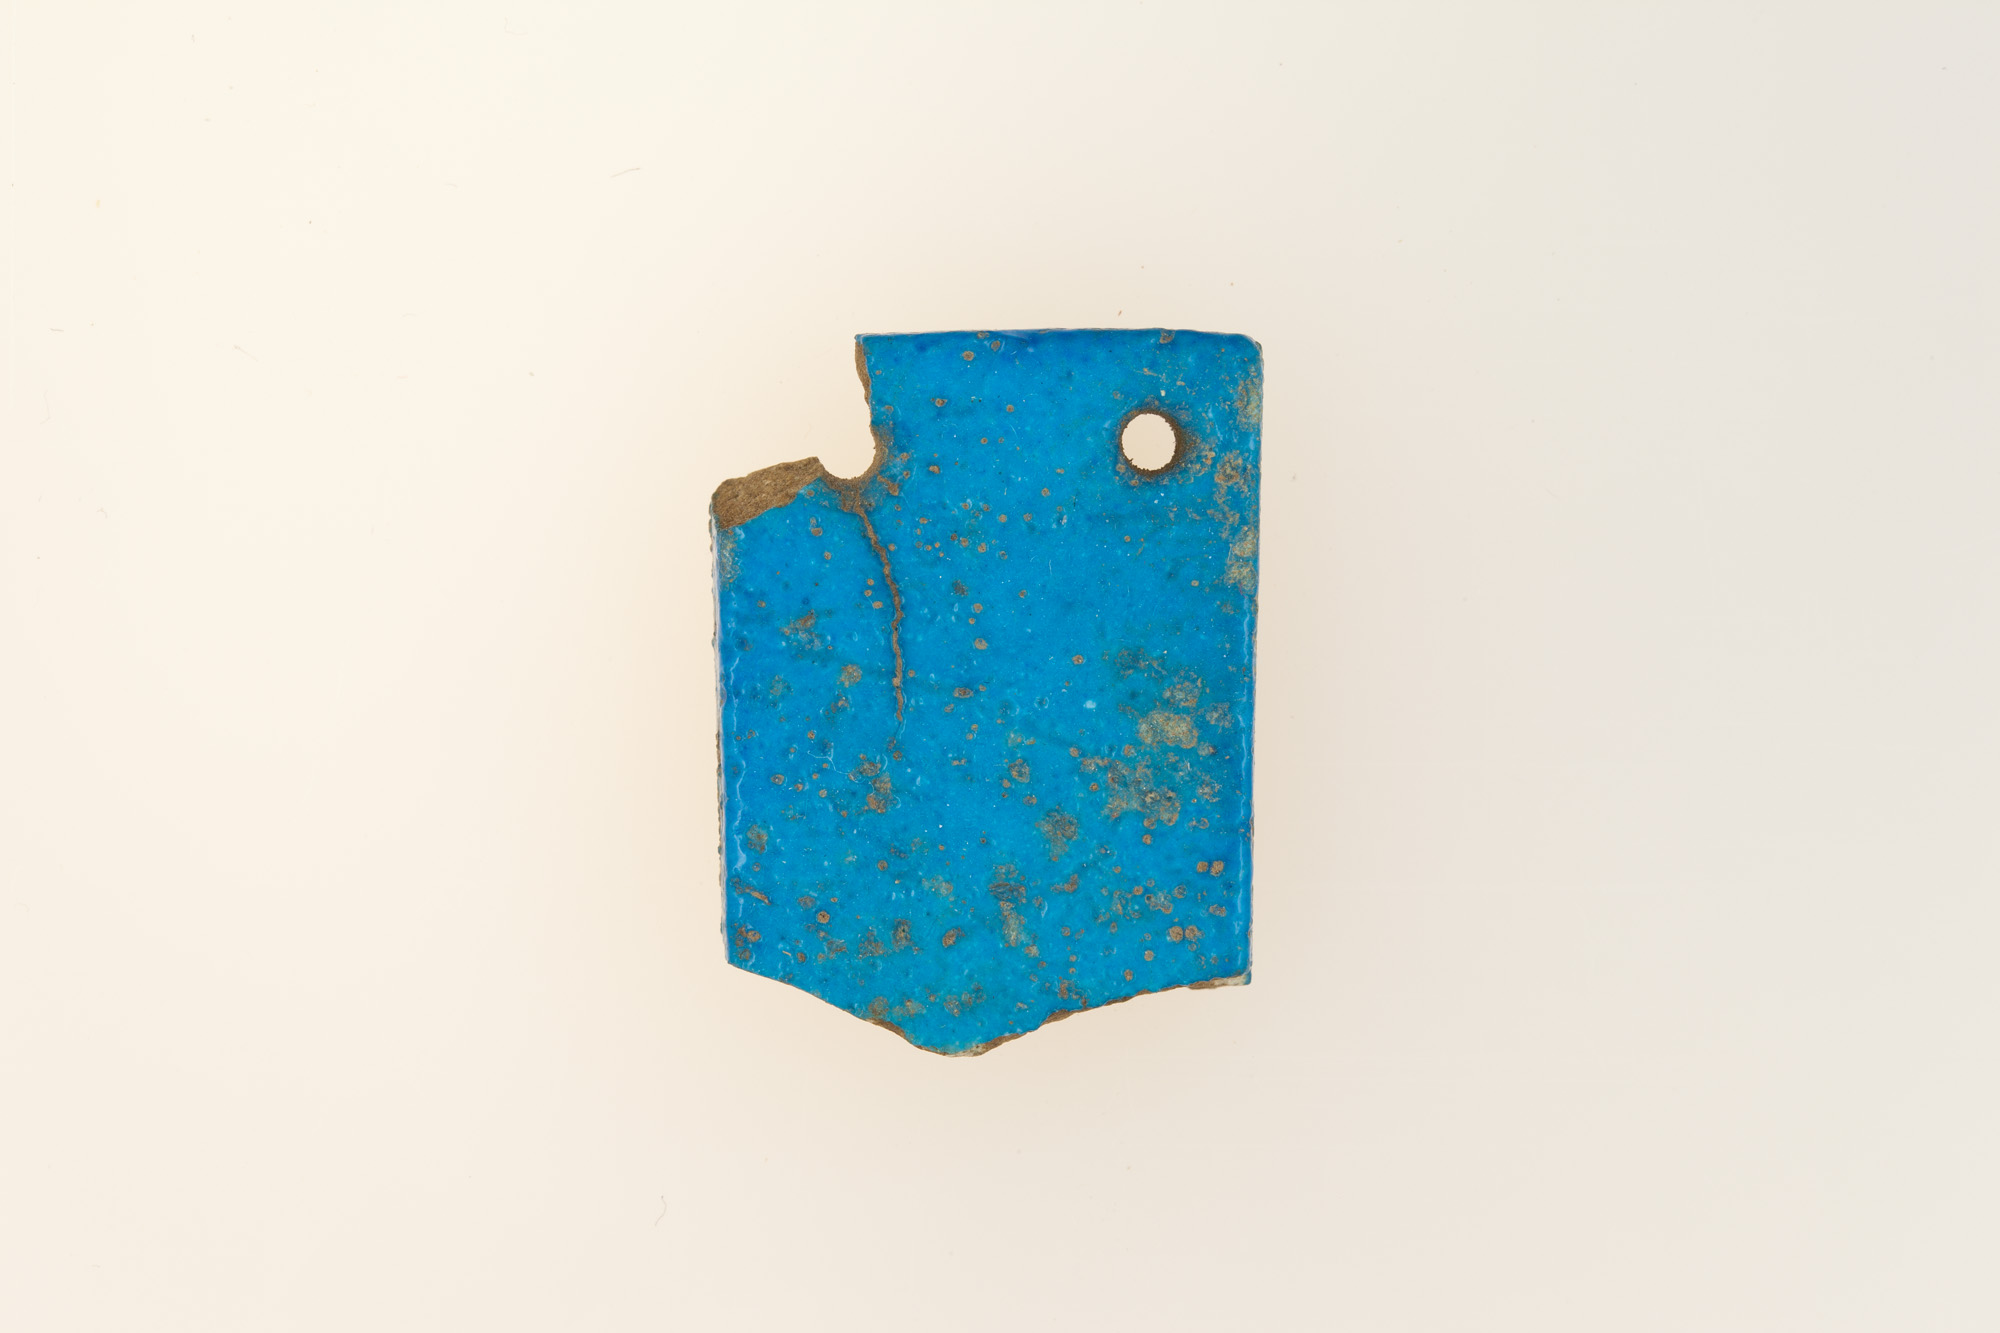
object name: menat fragment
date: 1479-1458 BCE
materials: faience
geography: egypt